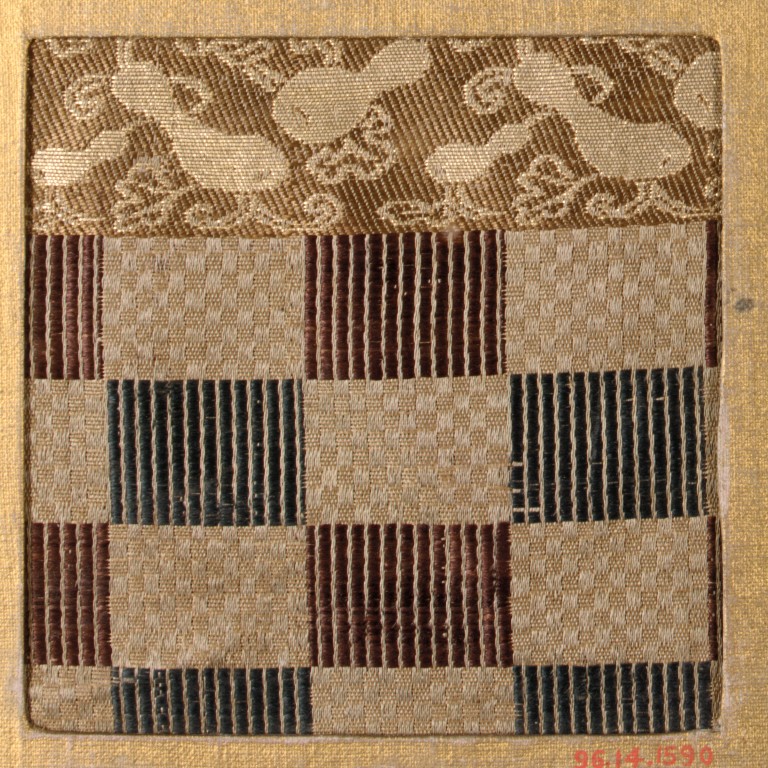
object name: piece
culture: japanese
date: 1701-1900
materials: silk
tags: gourds